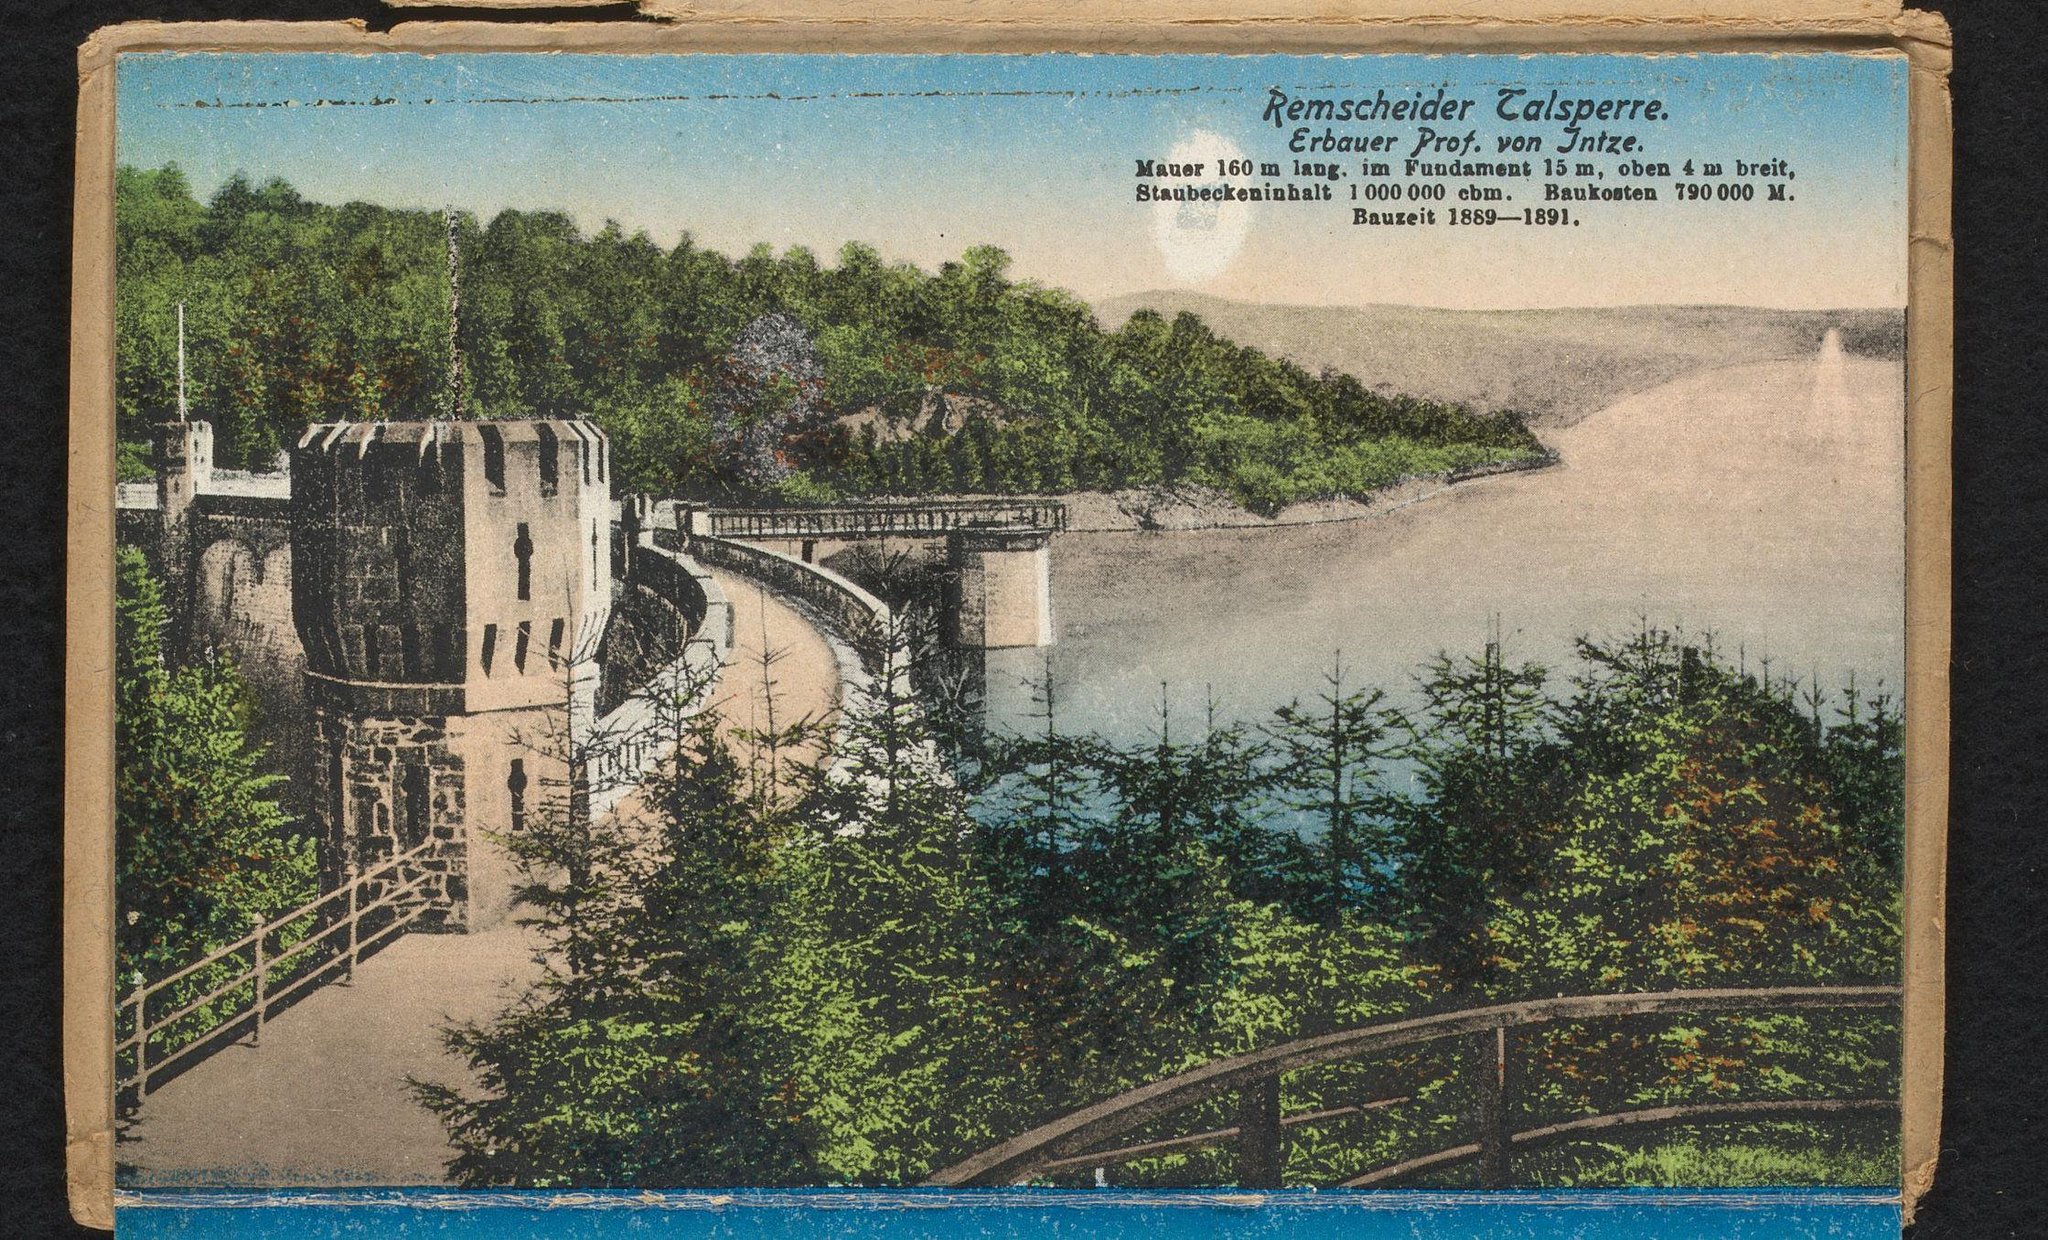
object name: photomechanical print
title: Remscheider Talsperre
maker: Anonymous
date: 1905-1930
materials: cardboard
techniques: lithograph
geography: remscheid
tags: dammed-up lake, lake, mountains